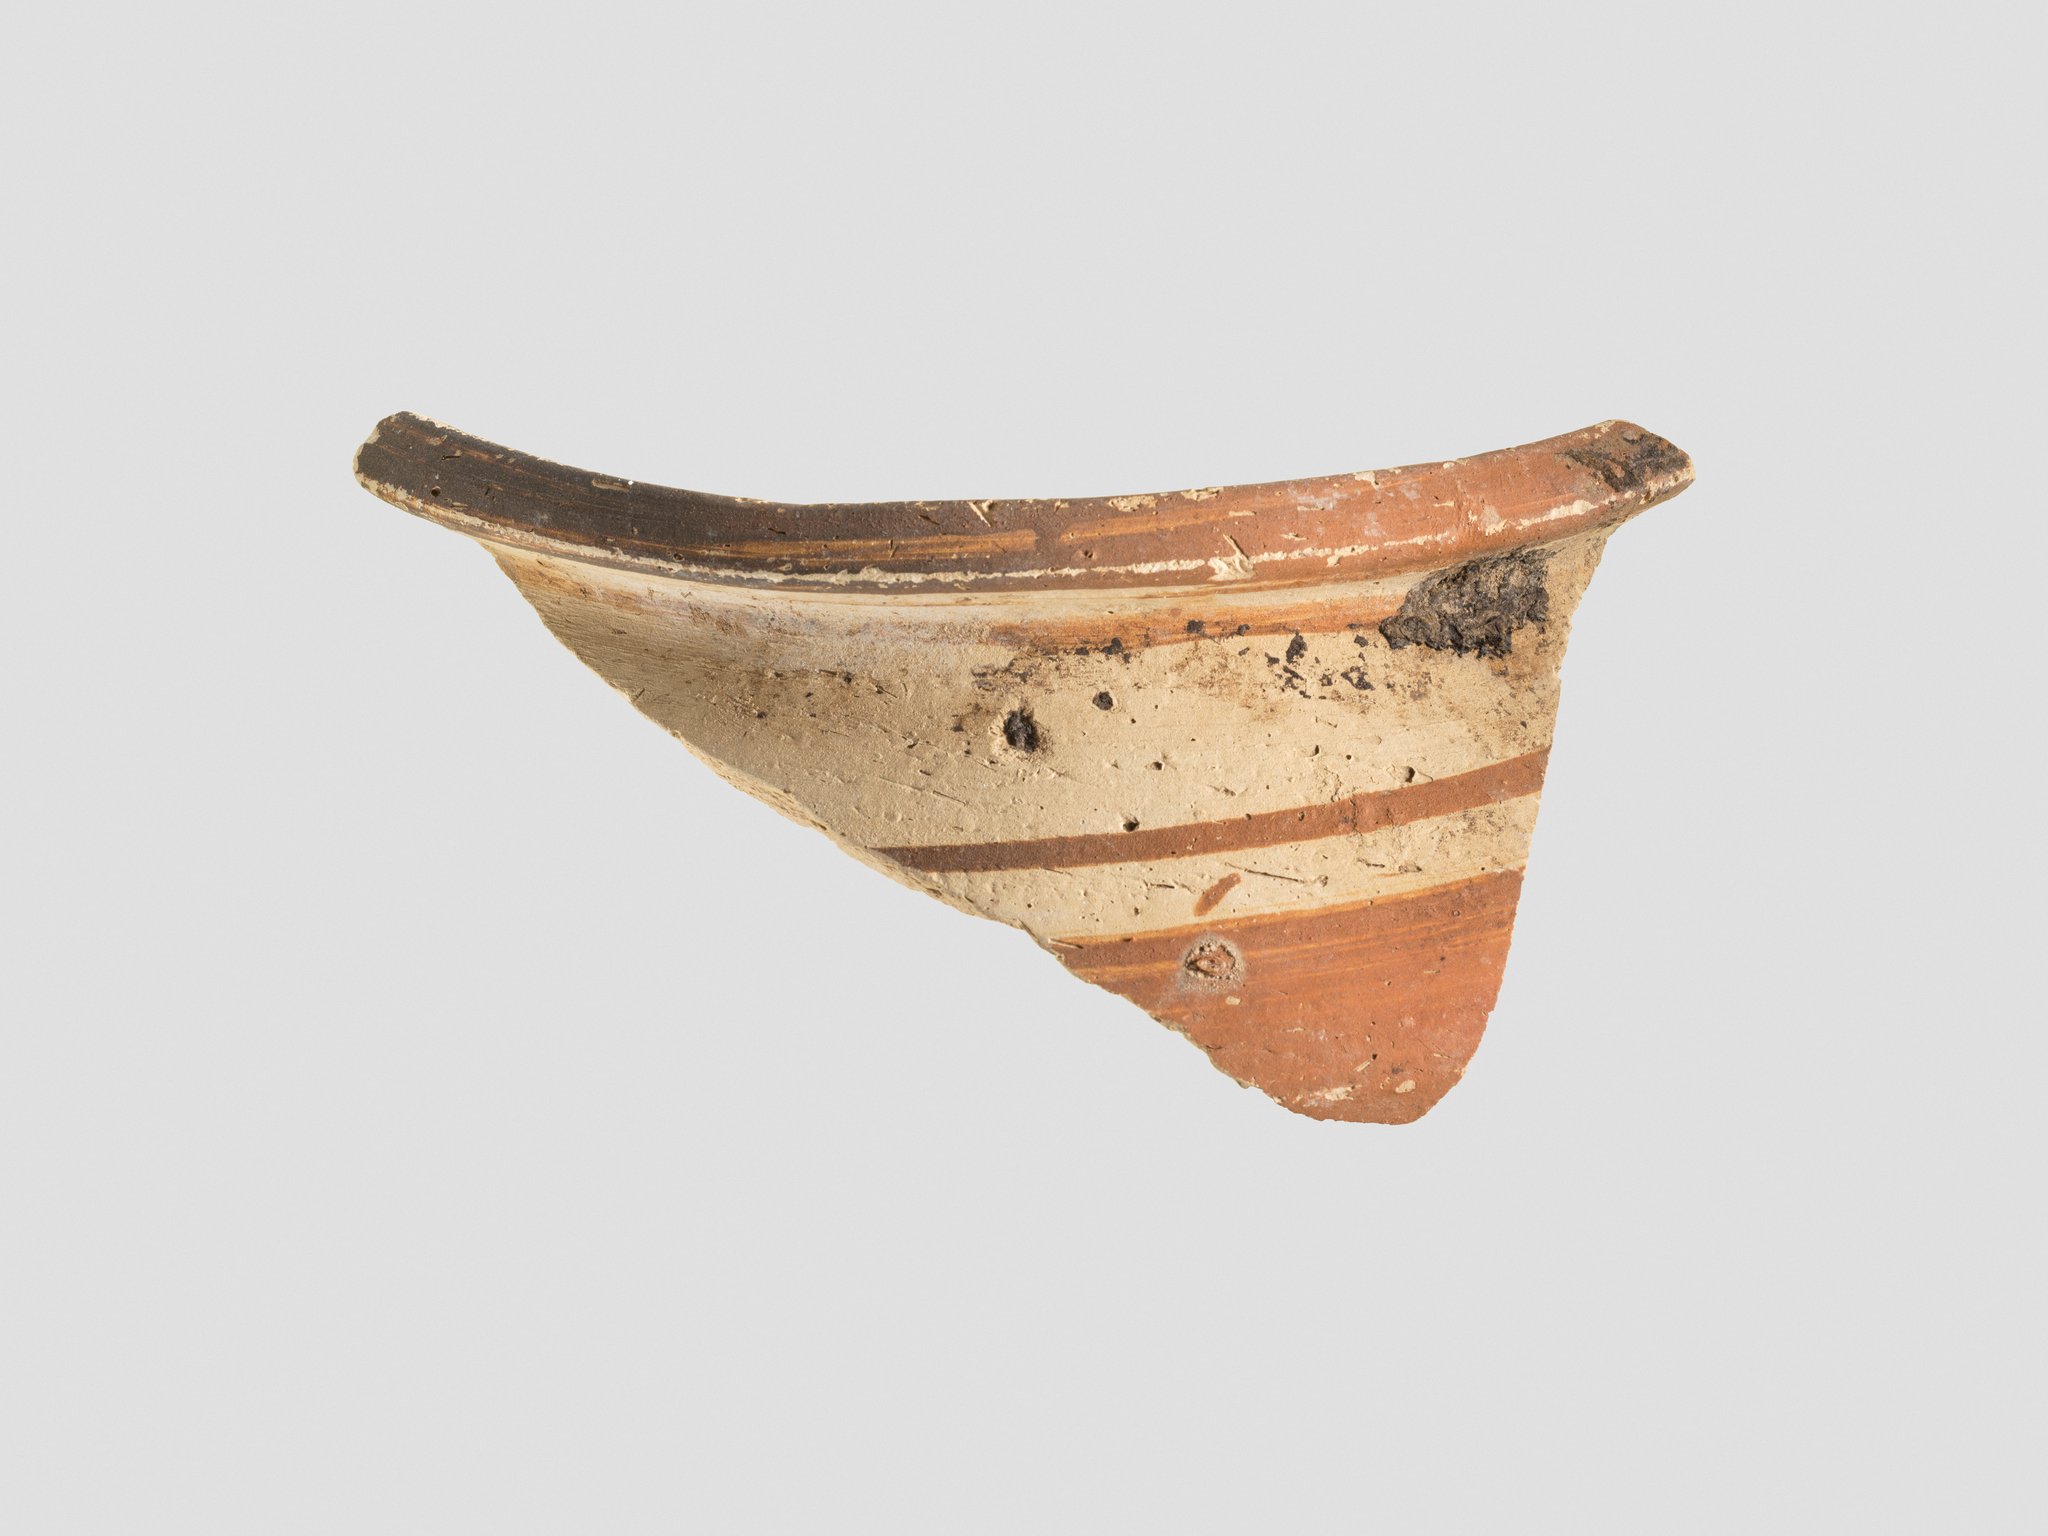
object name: sherd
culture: assyrian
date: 1800-1601 BCE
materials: ceramic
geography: mesopotamia